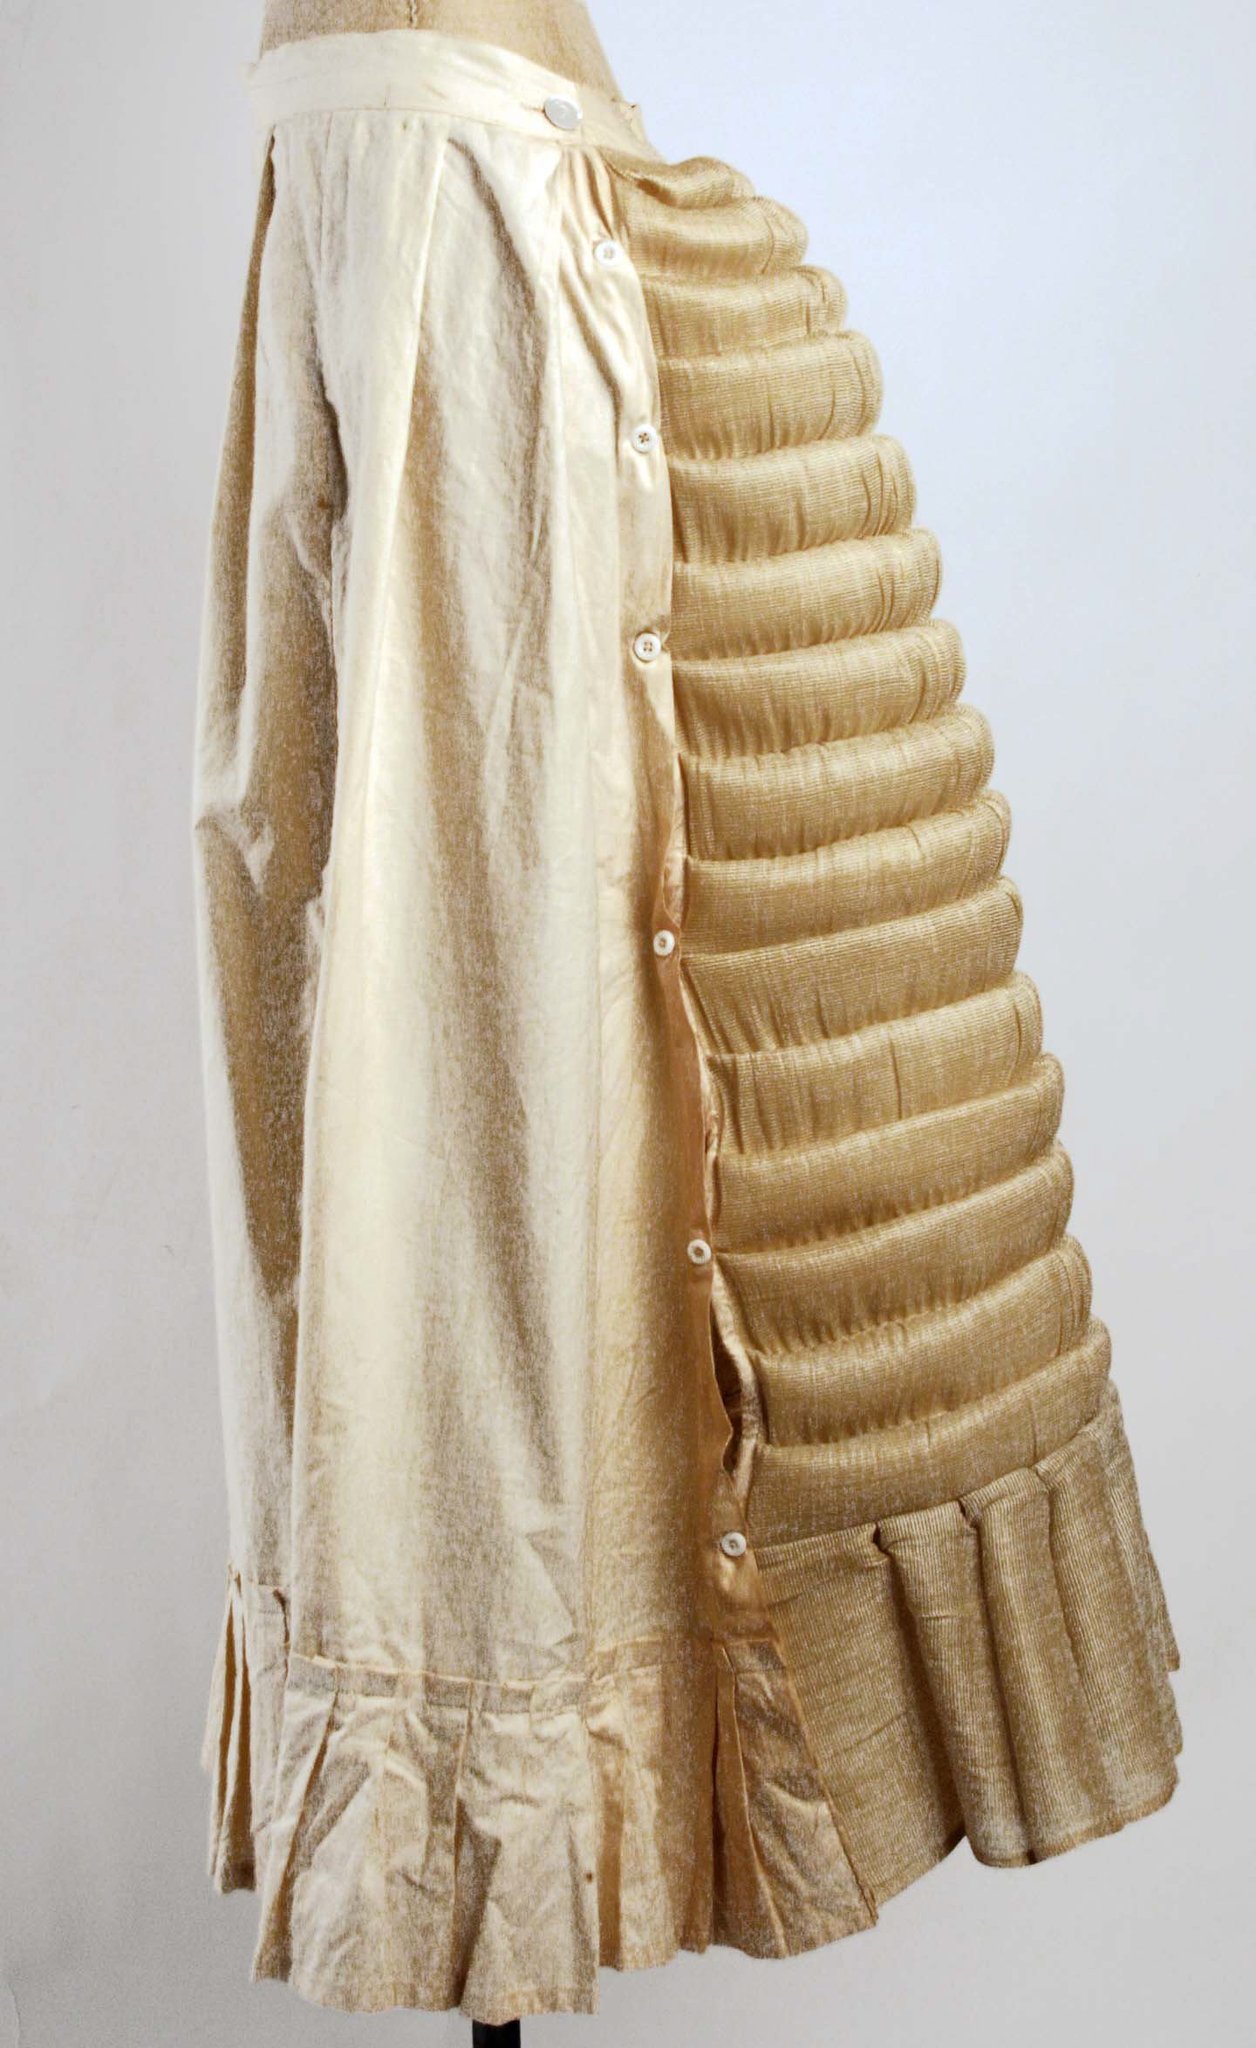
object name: bustle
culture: austrian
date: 1873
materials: cotton, hair